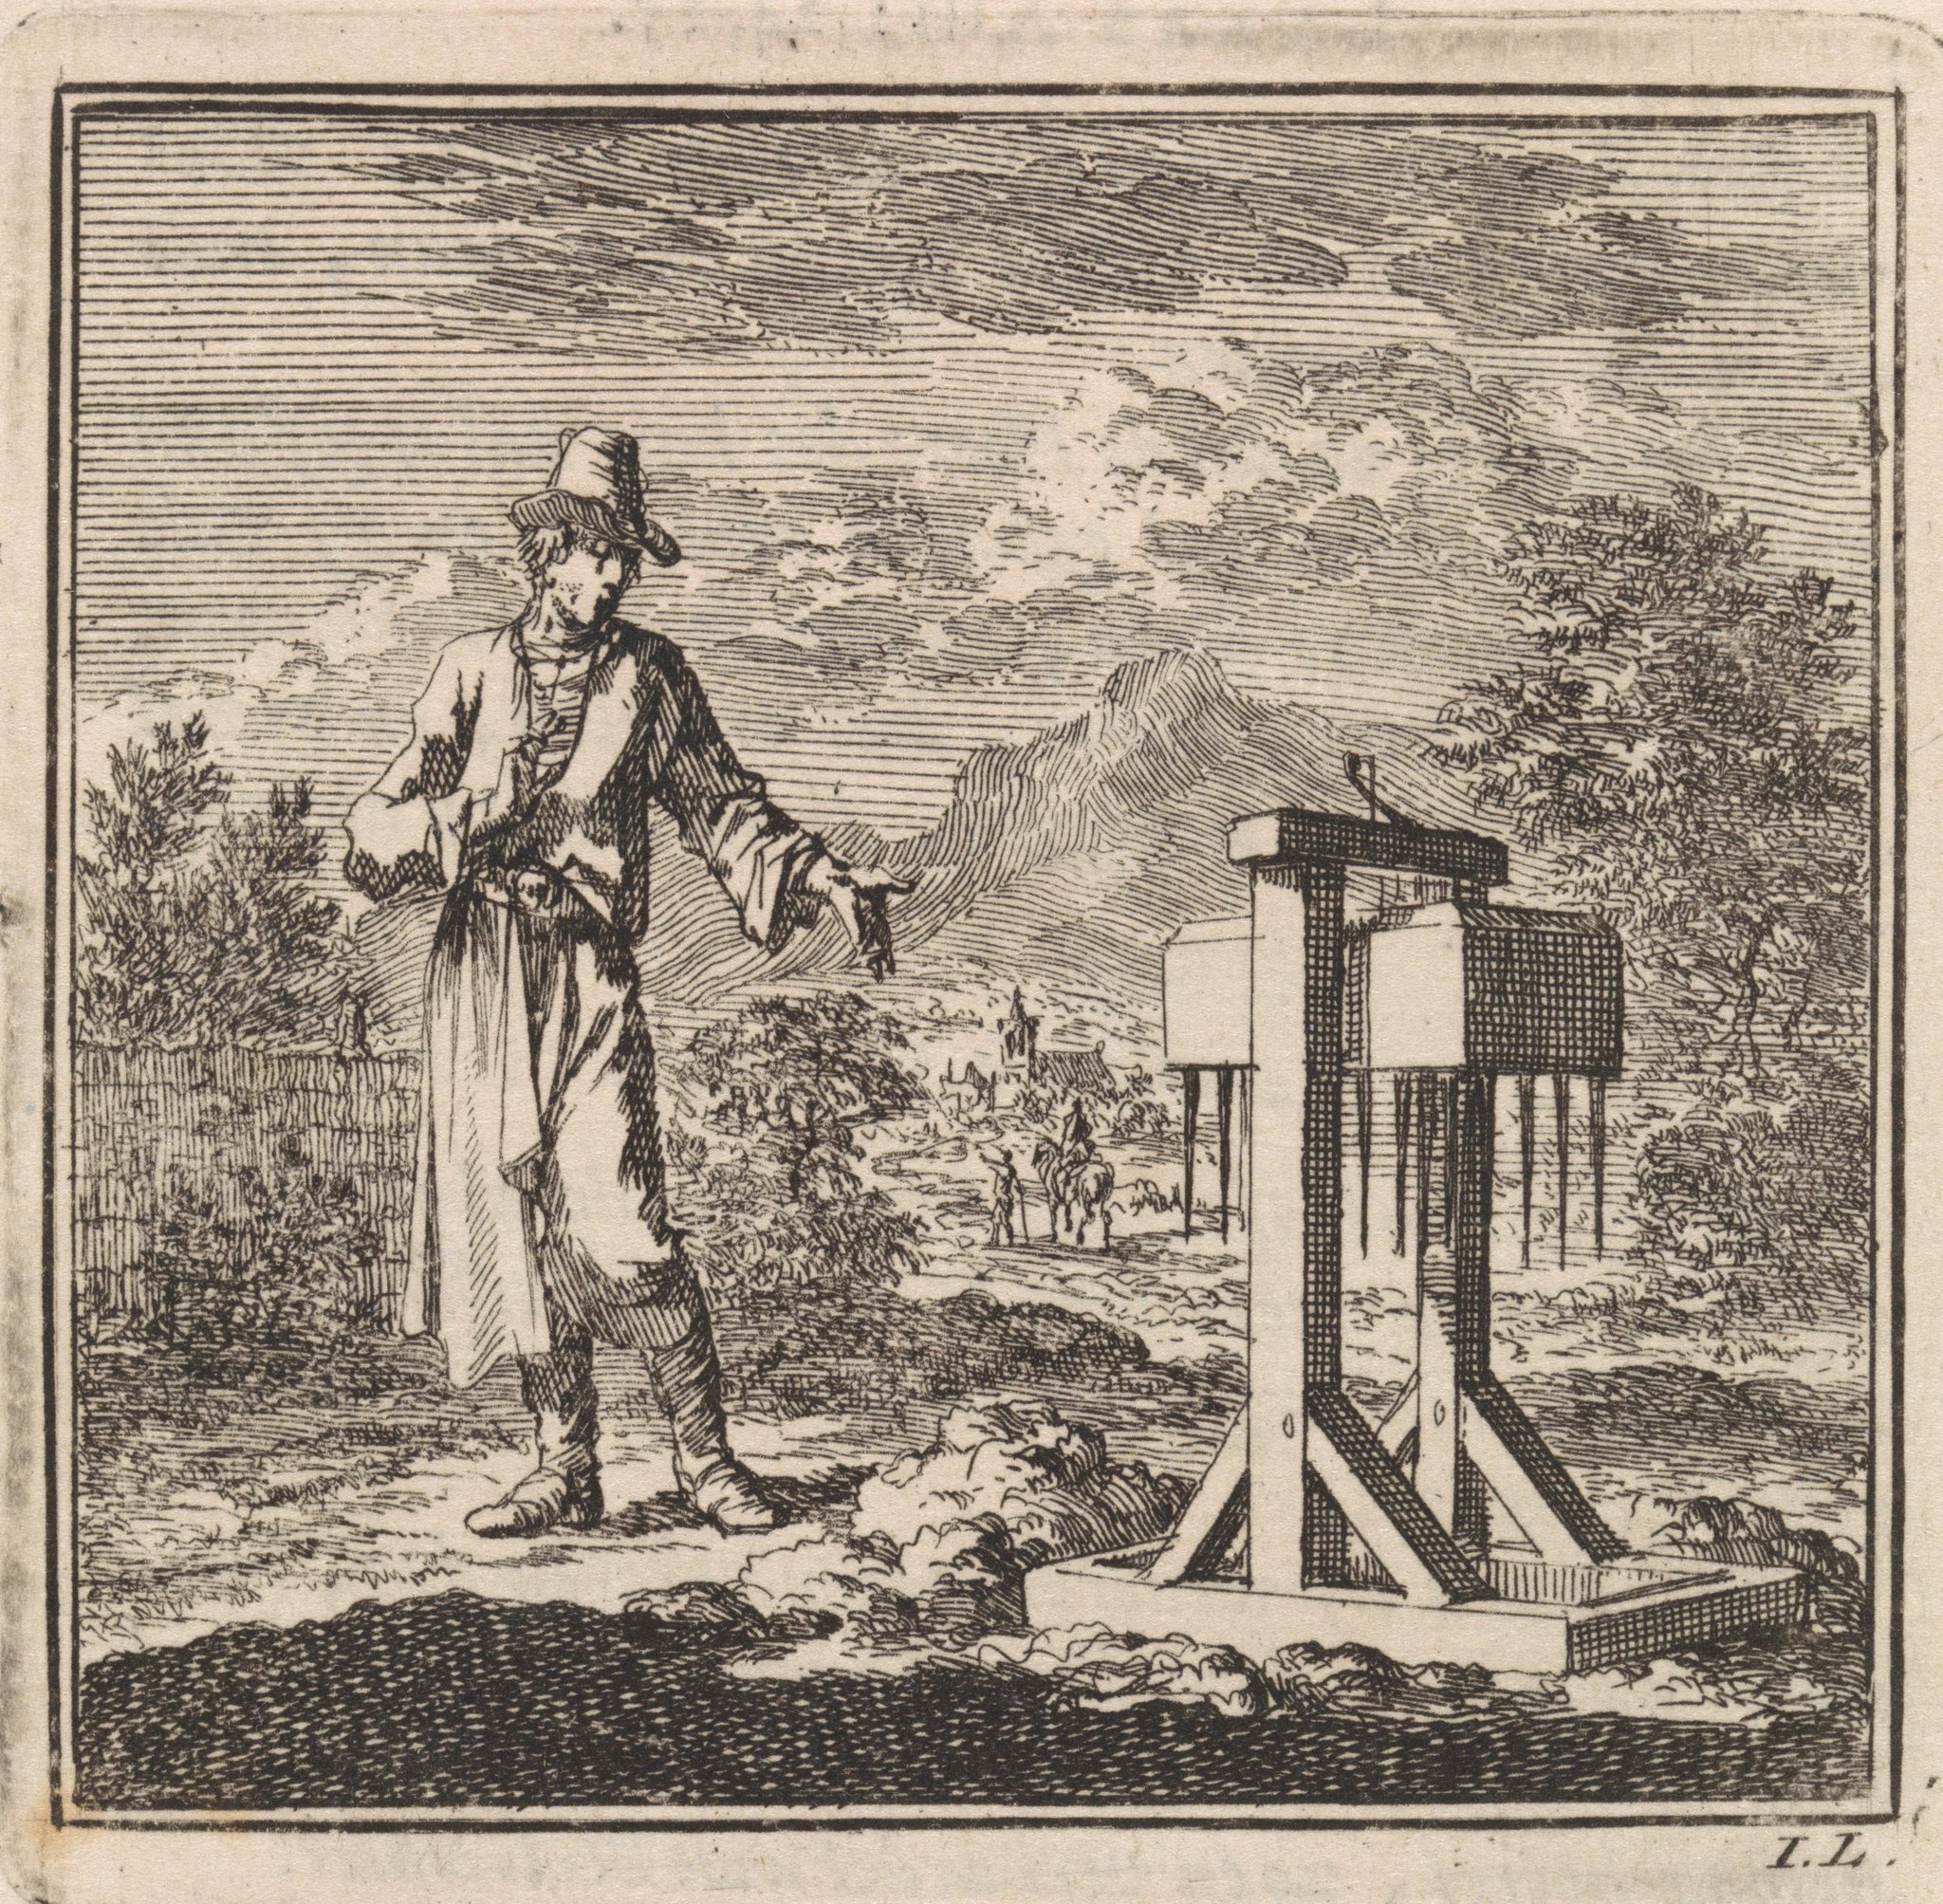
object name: print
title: Man wijst op een mollenval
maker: jan luyken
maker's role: draughtsman, print maker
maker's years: 1649-1712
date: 1711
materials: paper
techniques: etching, letterpress printing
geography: amsterdam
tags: other mammals: mole, finch trap, finchery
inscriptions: collector's mark: Lugt 2228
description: Illustratie voor: Luyken, Jan. De Bykorf des Gemoeds. Amsterdam: Pieter Arentsz. II (wed.) en Cornelis van der Sys, 1711, p. 74.